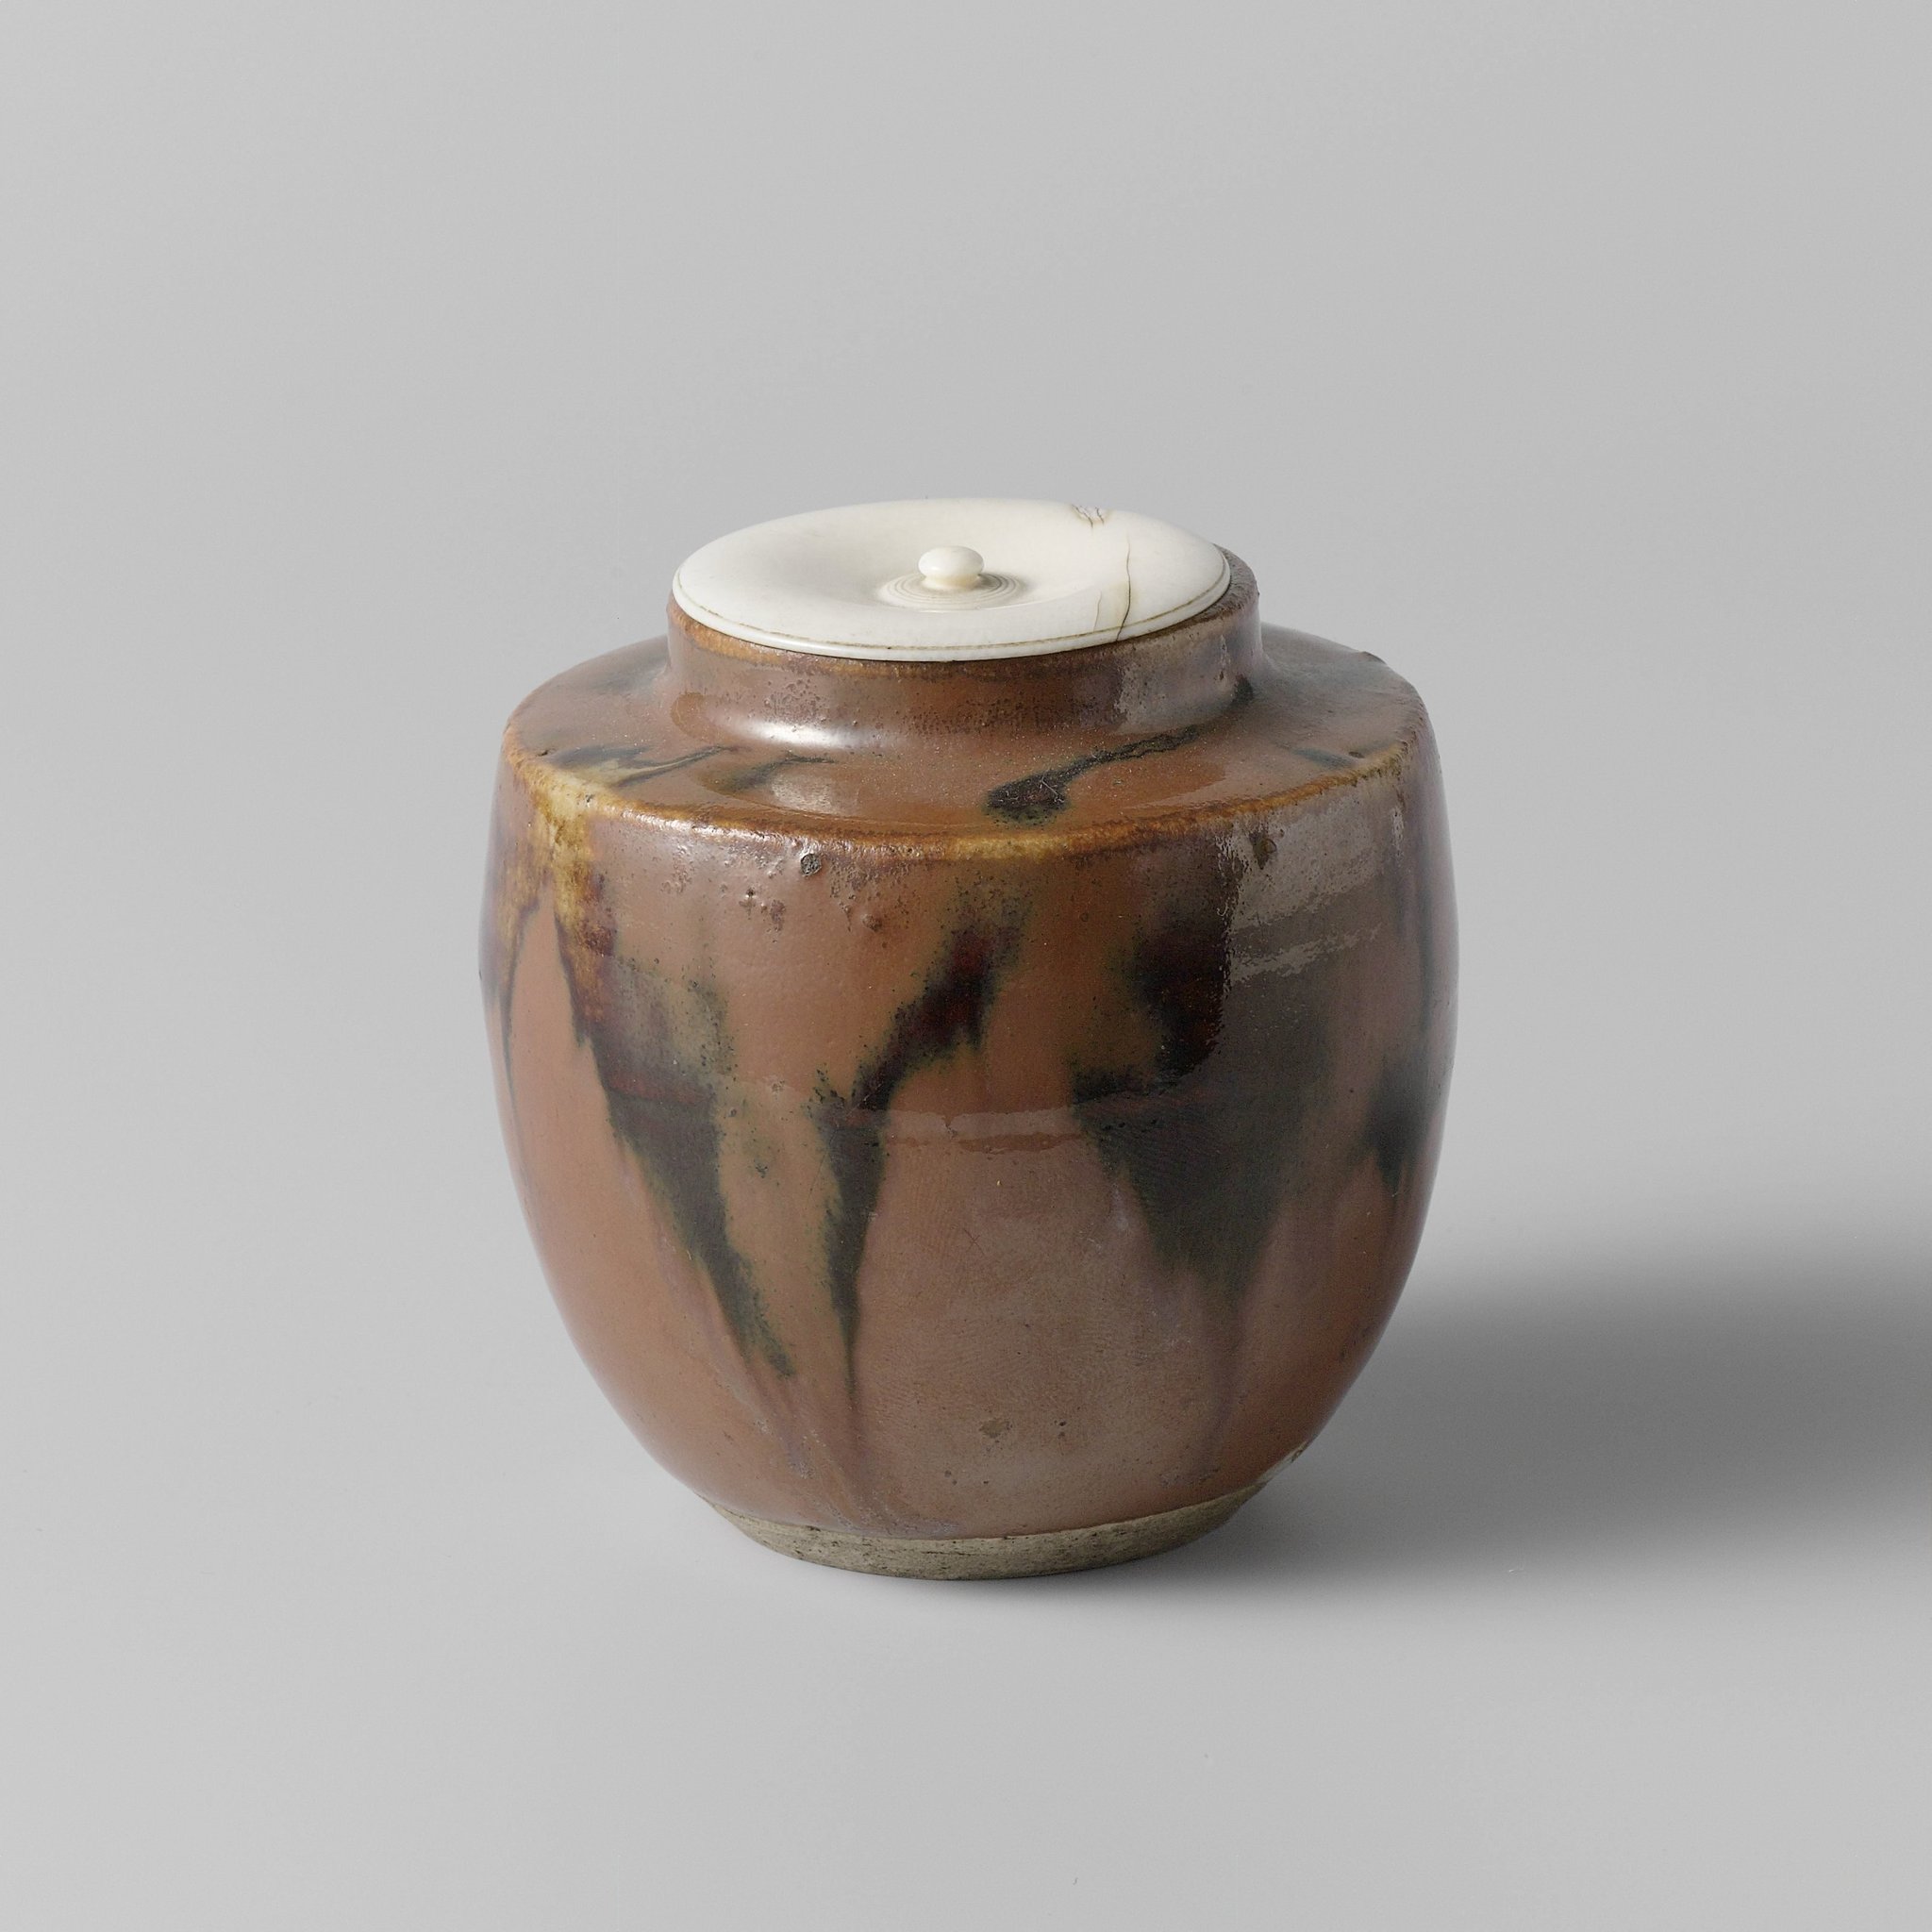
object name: chaire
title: Tea caddy with a green brown glaze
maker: Anonymous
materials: glaze, ivory, stoneware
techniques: firing, turning, vitrification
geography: seto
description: Tea caddy. Japan, central Honshû, Seto or Mino. 17th century. Stoneware, Seto or Mino ware. Westendorp bequest.